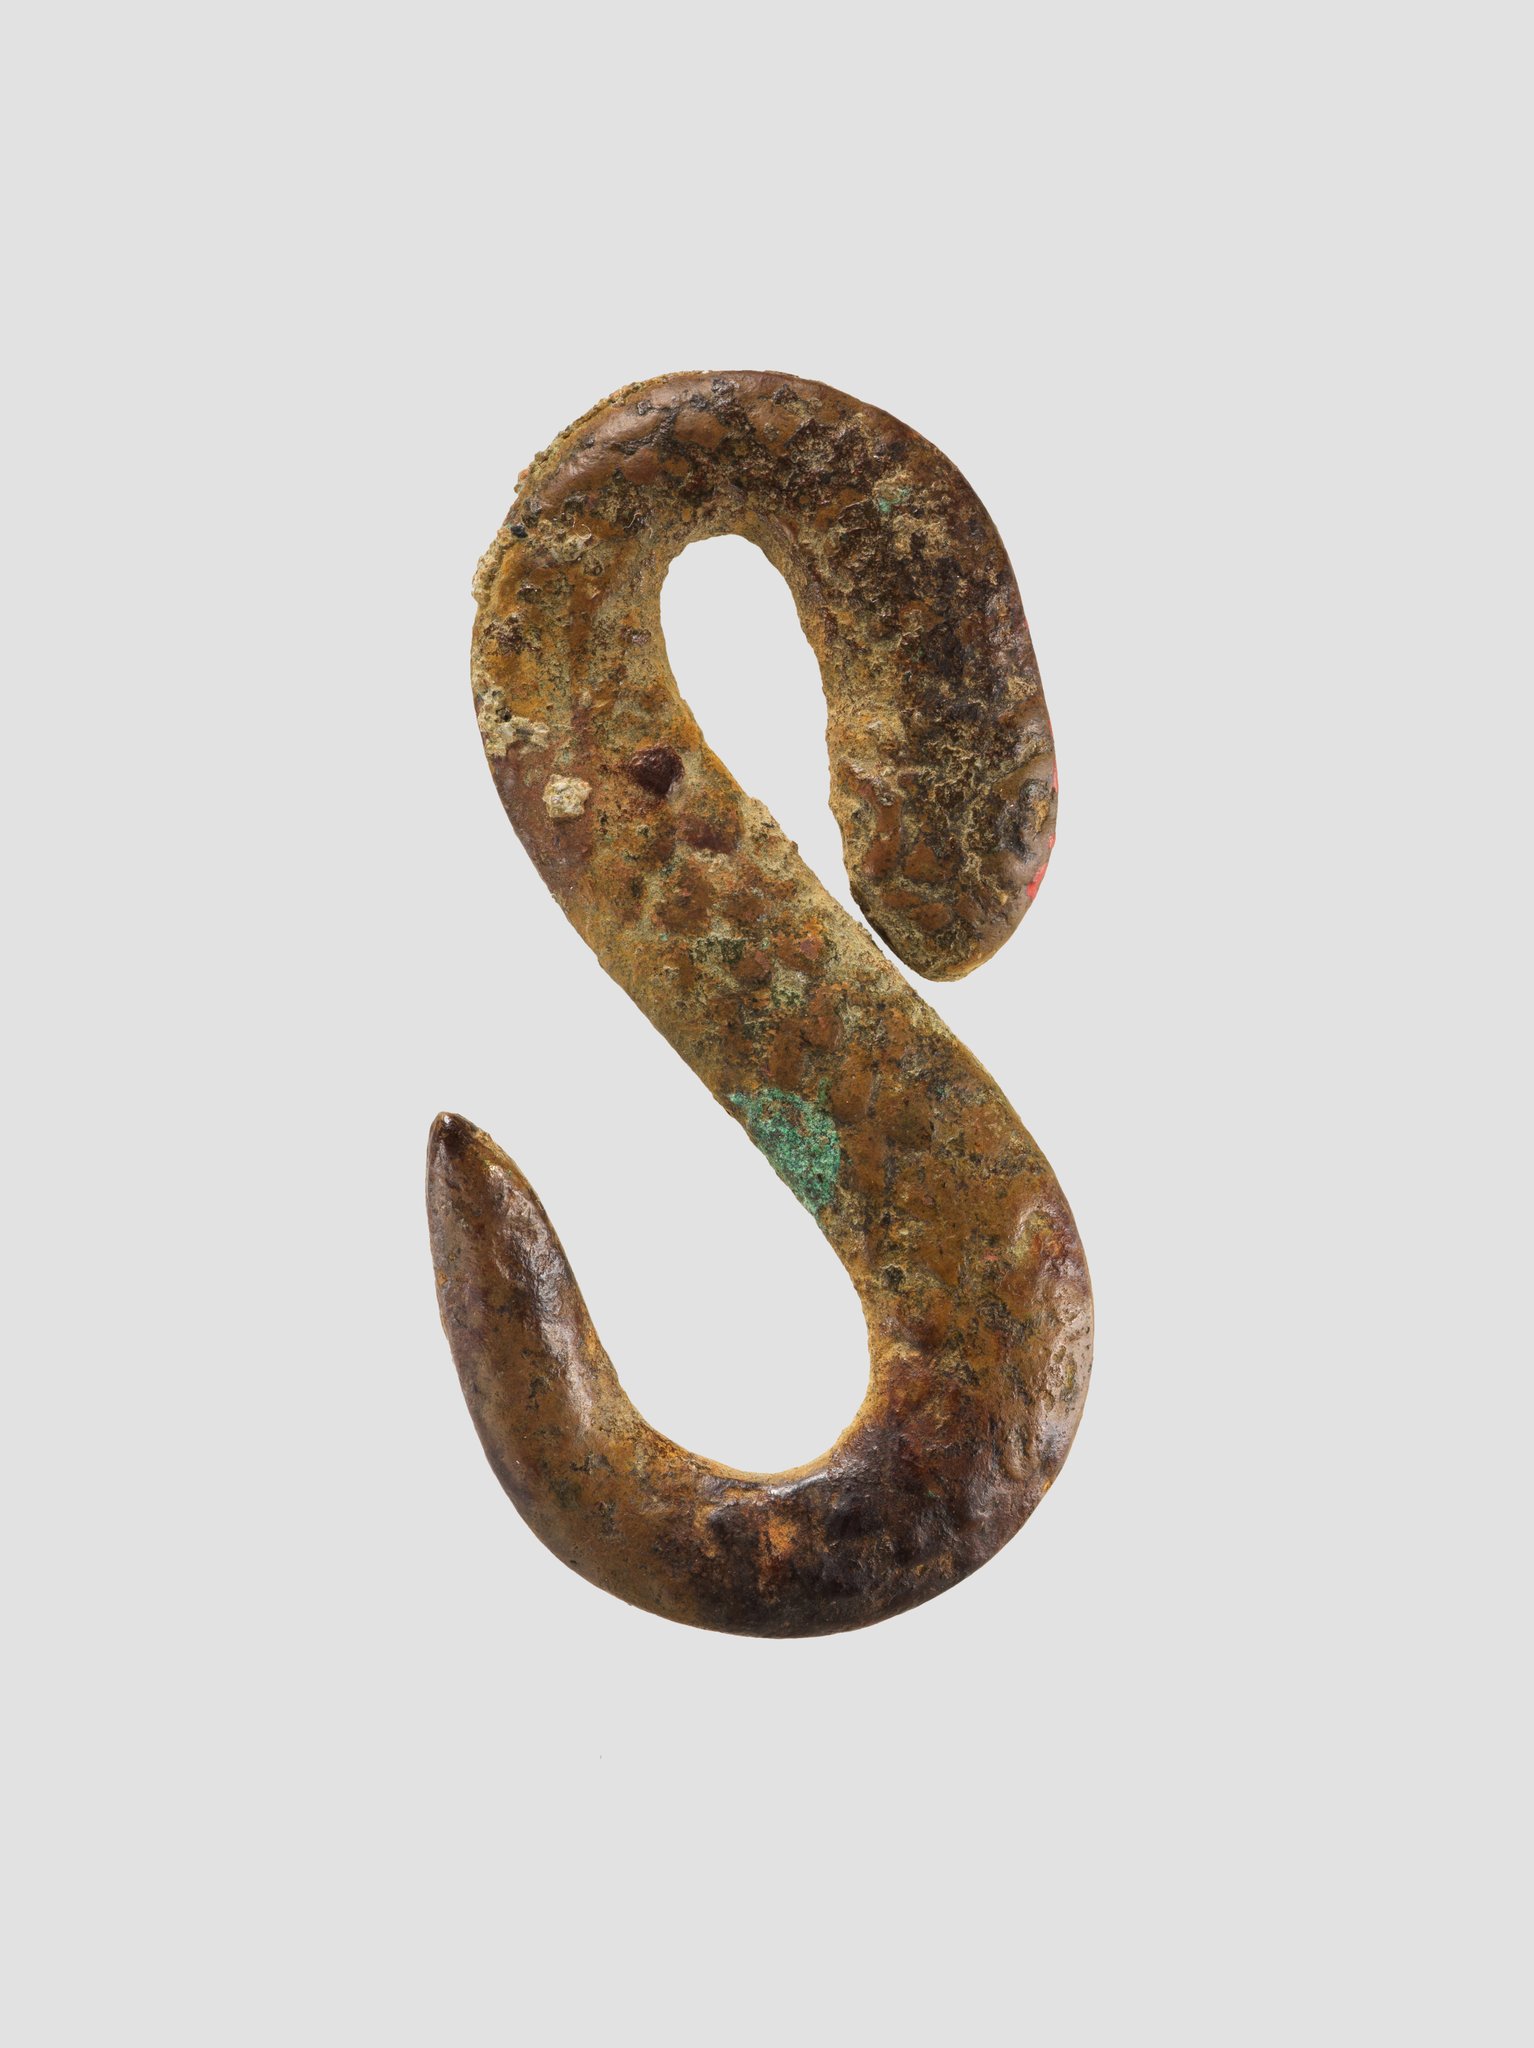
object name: ornament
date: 500-301 BCE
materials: bronze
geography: easterm eurasian steppes